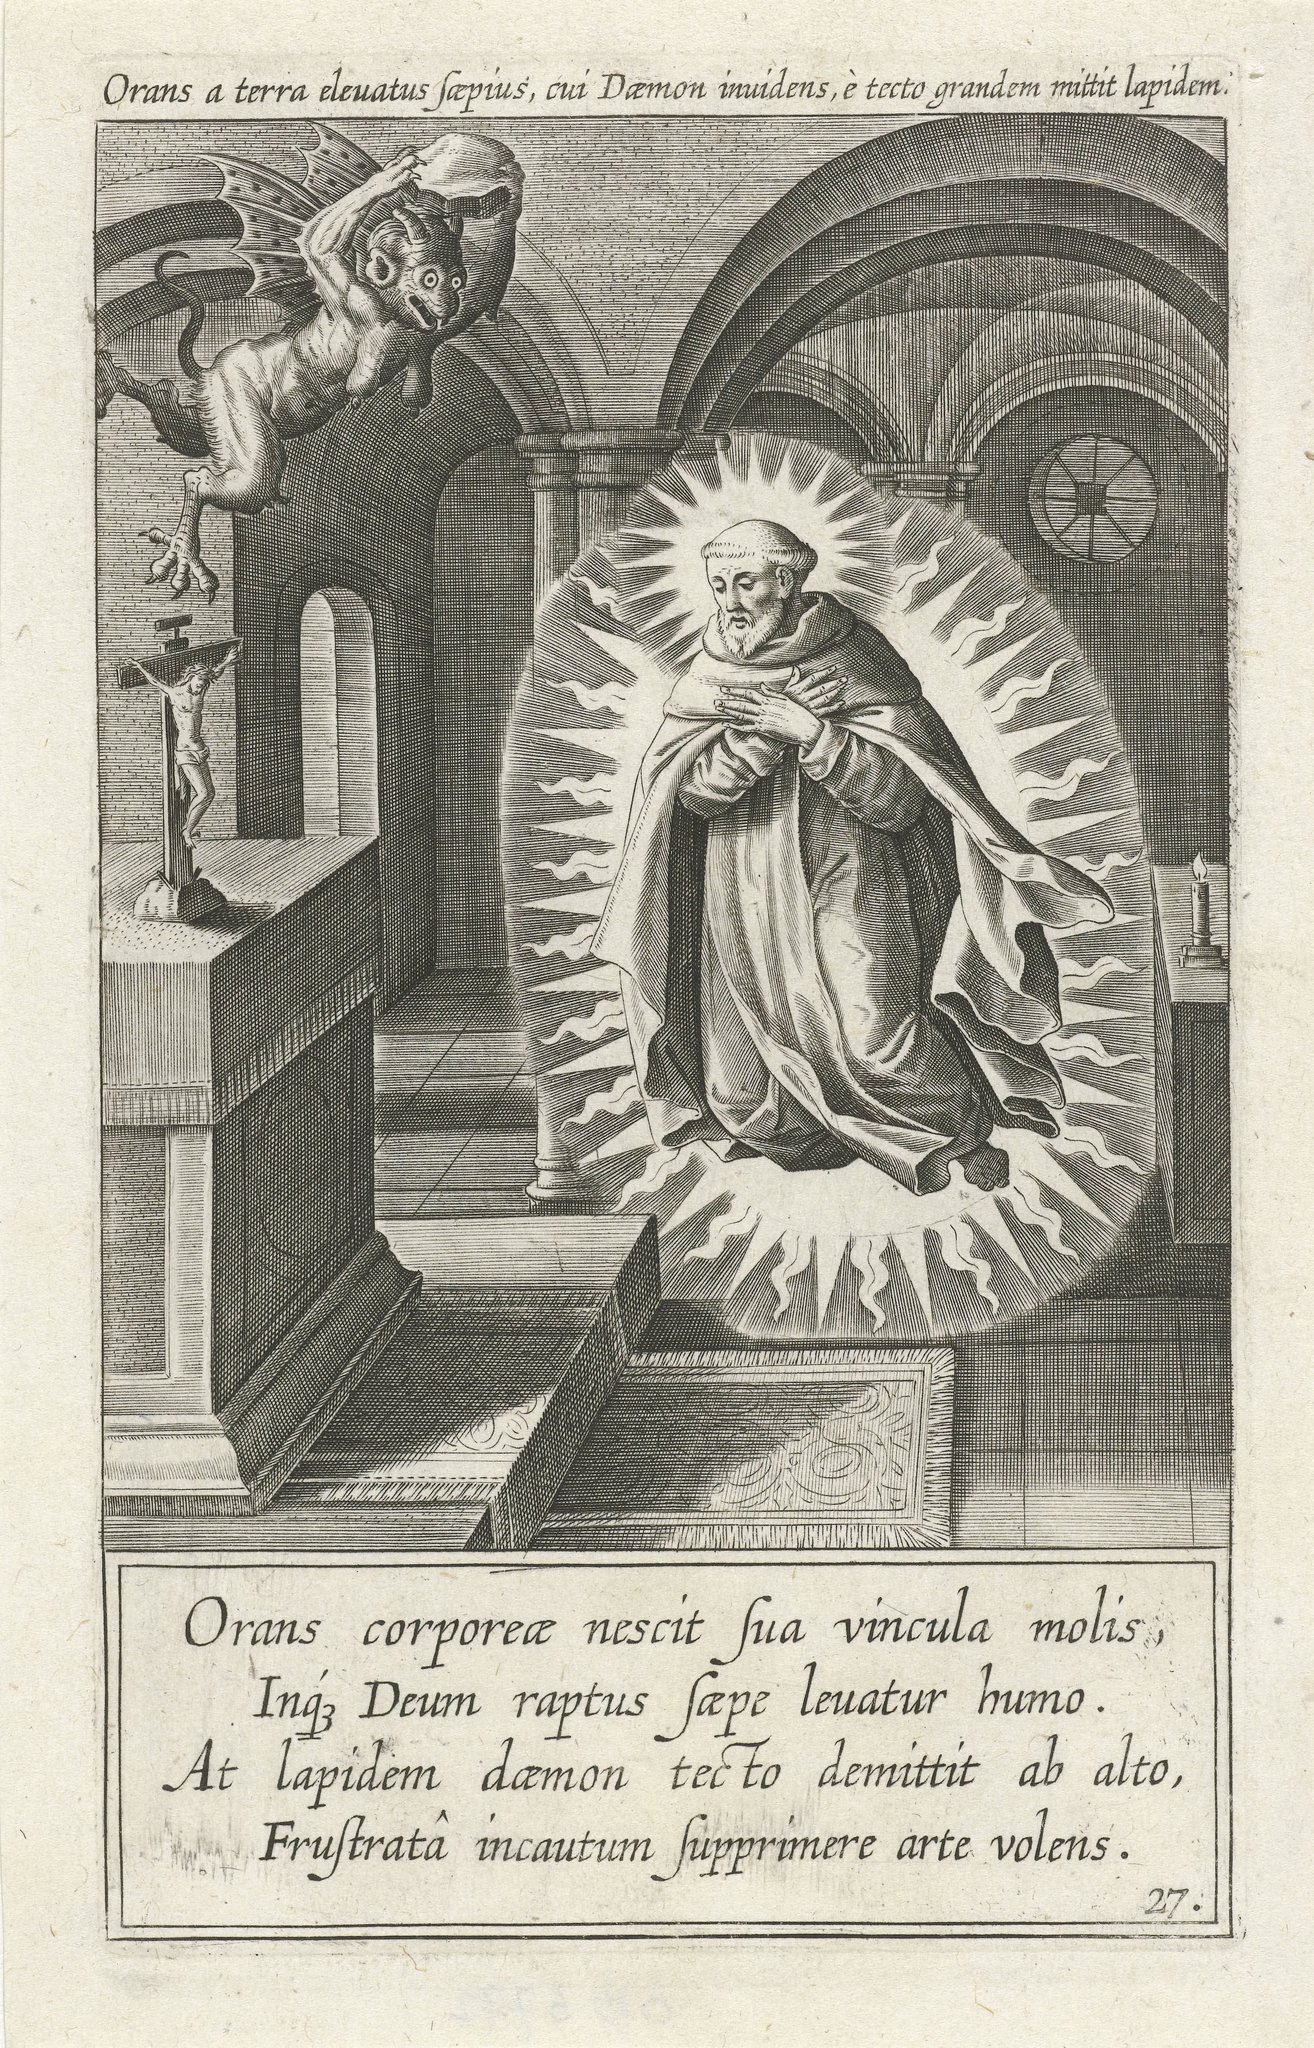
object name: book illustration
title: Leven en mirakels van de heilige Dominicus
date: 1611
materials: paper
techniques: engraving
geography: antwerp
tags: personal devotion of st. dominic - male saint meditating, in ecstasy (+ devil(s))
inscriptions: collector's mark: Lugt 2228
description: De heilige Dominicus bidt in een kerk voor een altaar. Terwijl hij in extase is, verschijnt een duivel in de kerk die de heilige Dominicus wil verwonden door een steen naar hem te gooien. De prent heeft een Latijns opschrift en onderschrift en maakt deel uit van een prentserie voor een boek over het leven van de heilige Dominicus.